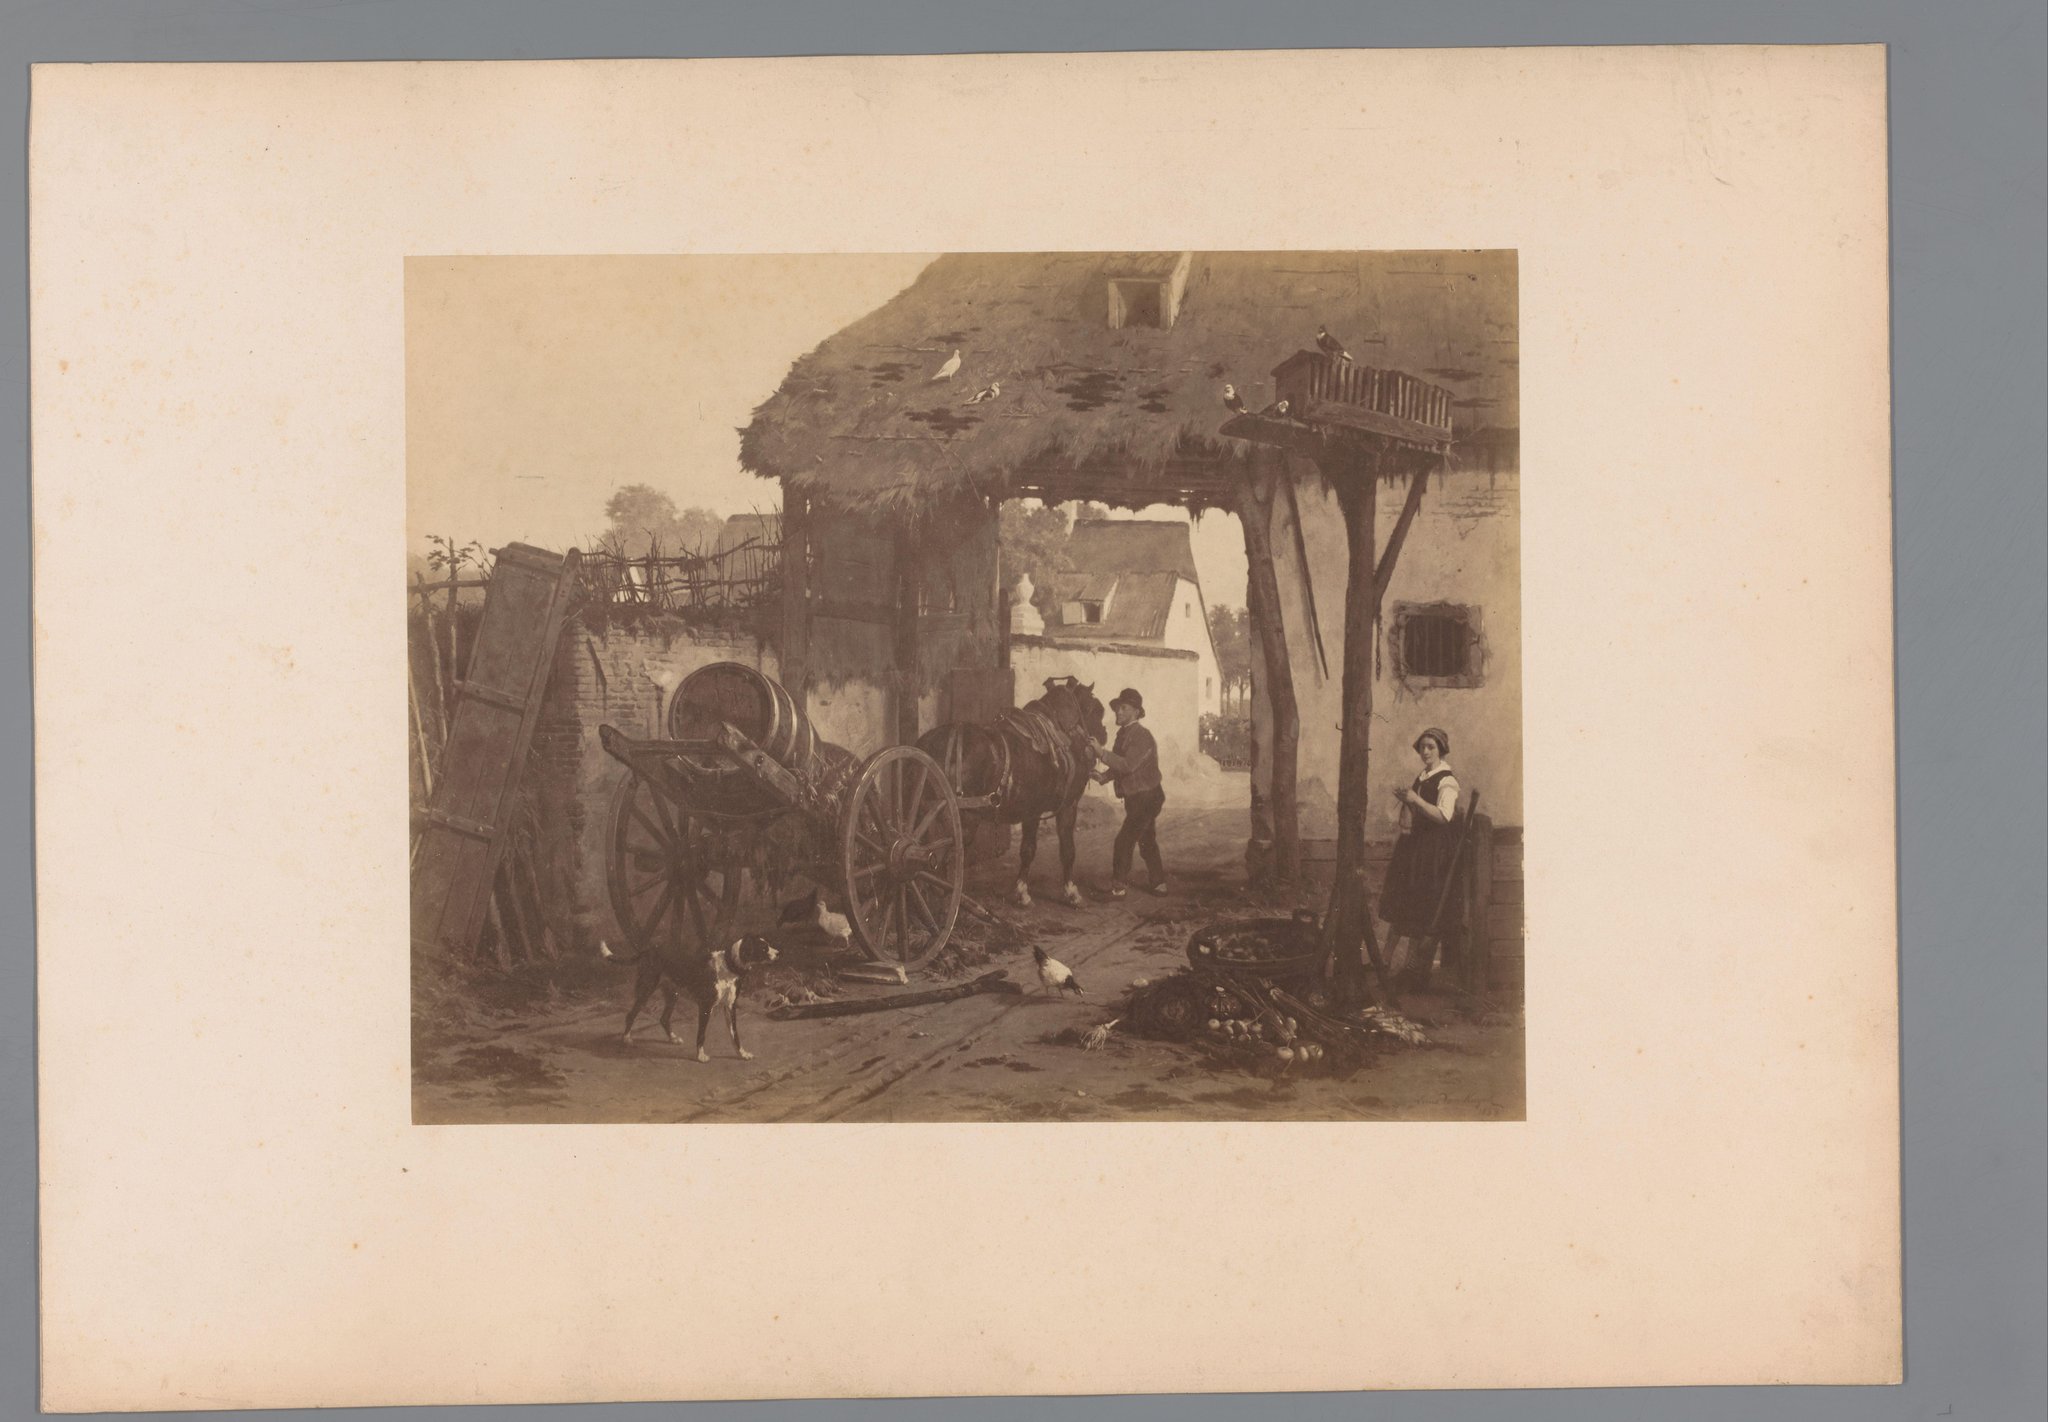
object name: photograph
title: Fotoreproductie van een schilderij van het erf van een boerderij door Jean Louis van Kuyck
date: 1858-1863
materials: photographic support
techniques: albumen print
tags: farmers, farm (building)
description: Deze foto maakt deel uit van een omslag met twaalf foto's en twee tekstbladen.